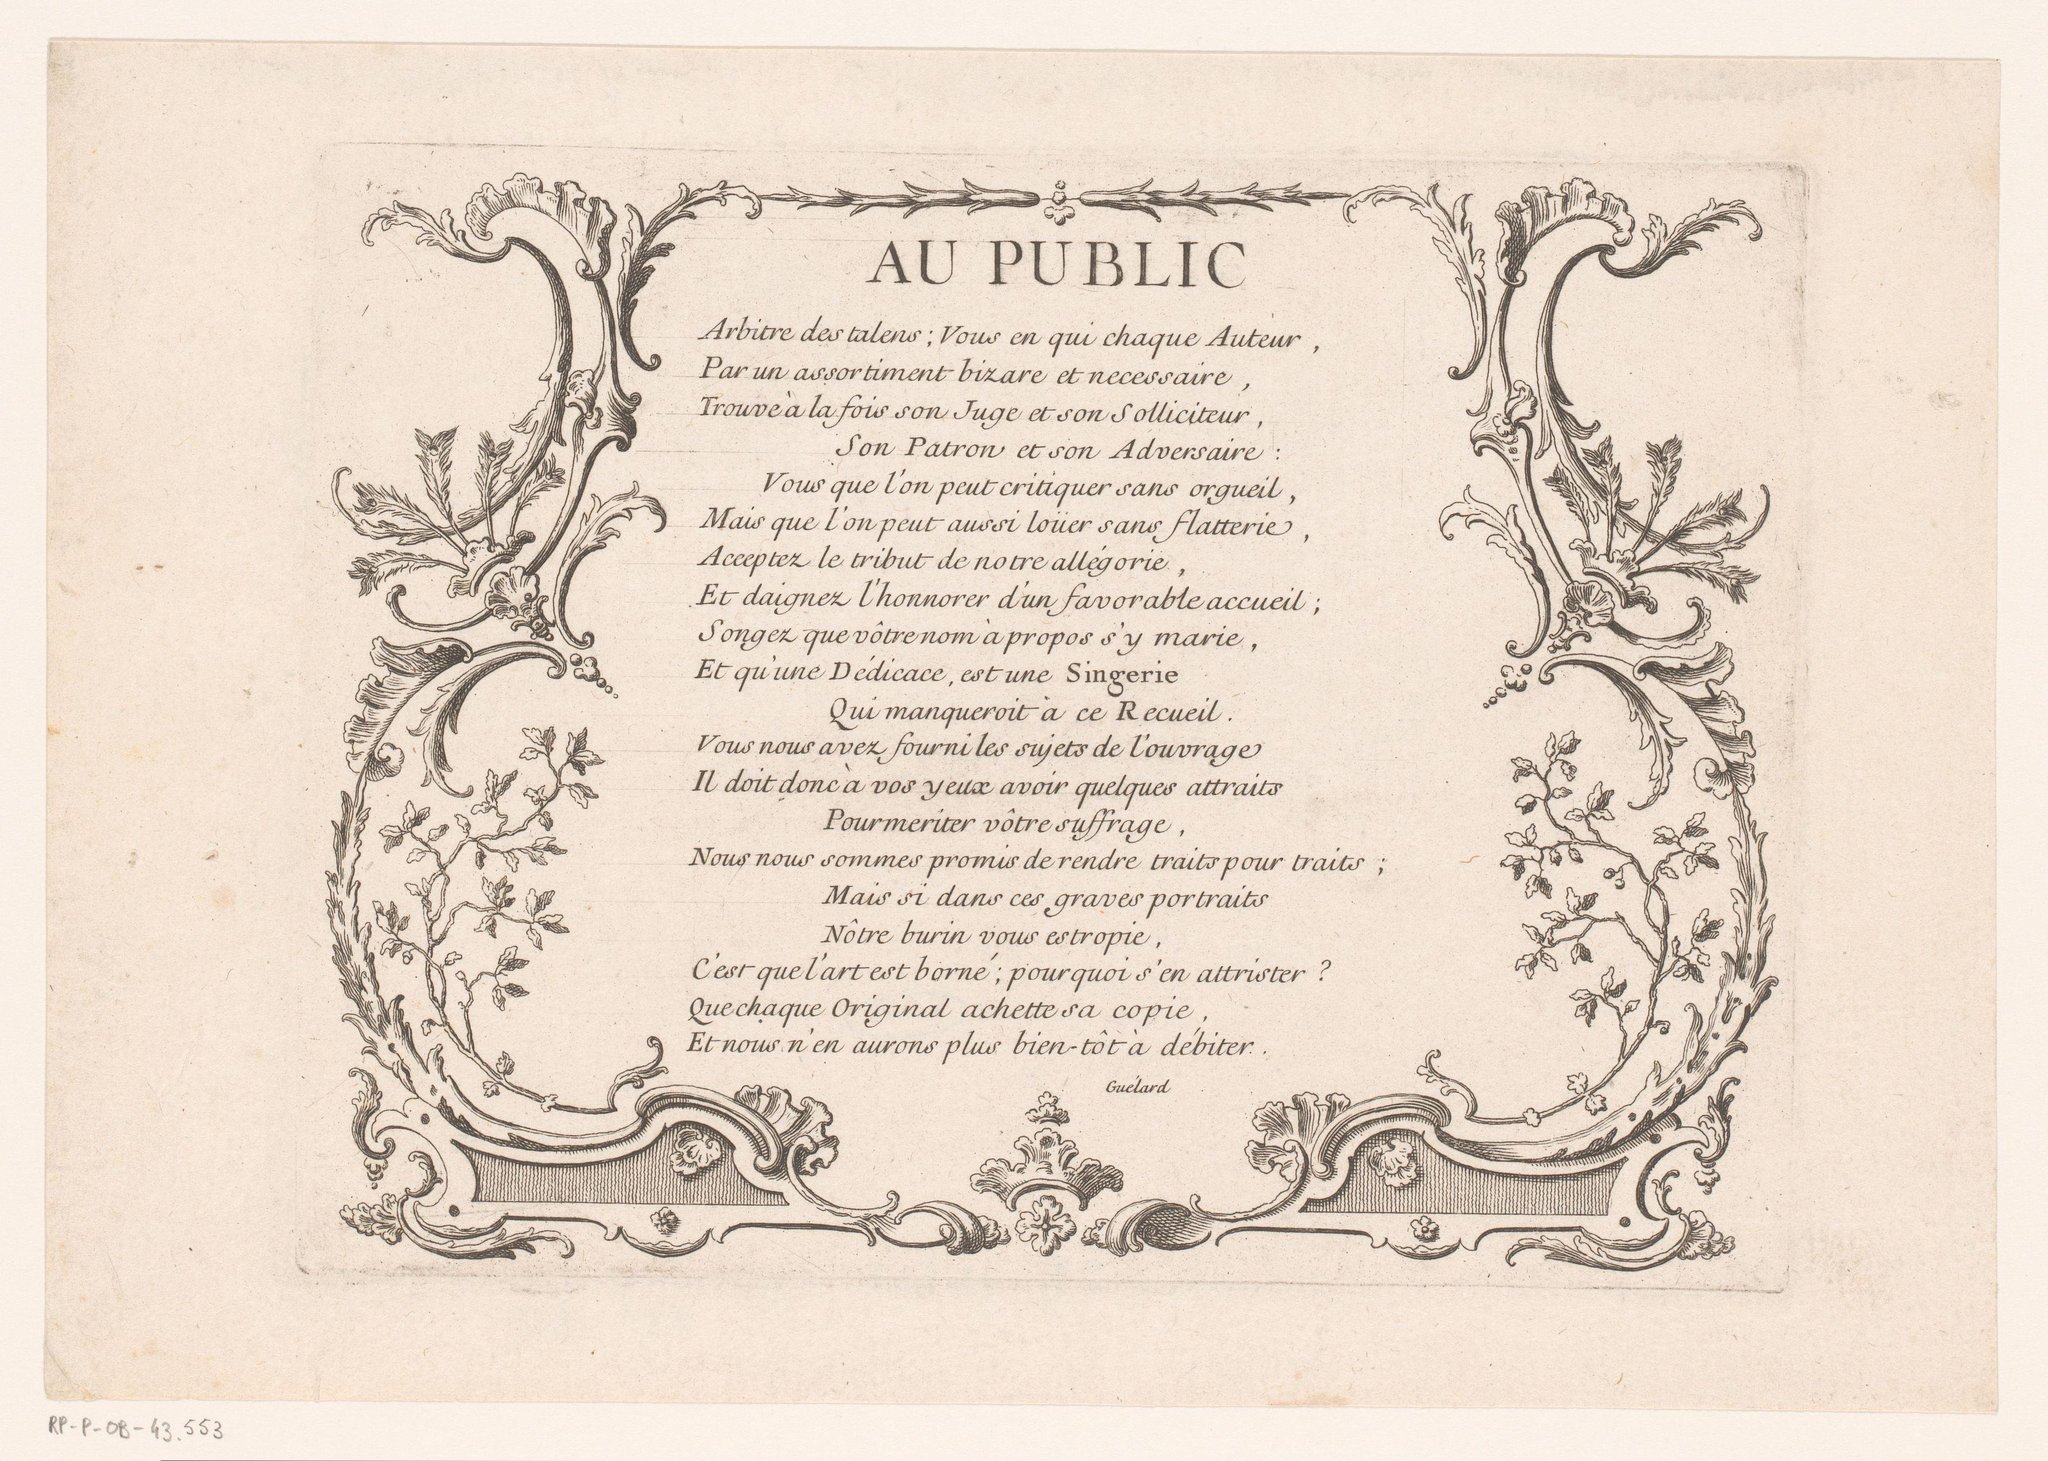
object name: print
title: Opdracht in cartouche met bloemmotief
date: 1733-1792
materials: paper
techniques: etching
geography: paris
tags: ornament ~ cartouche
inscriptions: collector's mark: Lugt 2228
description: Opdracht van een twaalfdelige serie getiteld 'Singeries ou differentes Actions de la Vie humaine', met apenspelen. De serie bestaat uit twee delen met elk twaalf platen en een opdracht. Deze serie is opgedragen aan het publiek (Au Public). Het andere deel werd opgedragen aan Monsieur de l'Orme van de Ménagerie de Versailles. De serie werd initieel uitgegeven door Guélard en de weduwe van Chéreau. Dit betreft waarschijnlijk een door het IFF onbeschreven latere staat, uitgegeven door Étienne Charpentier.